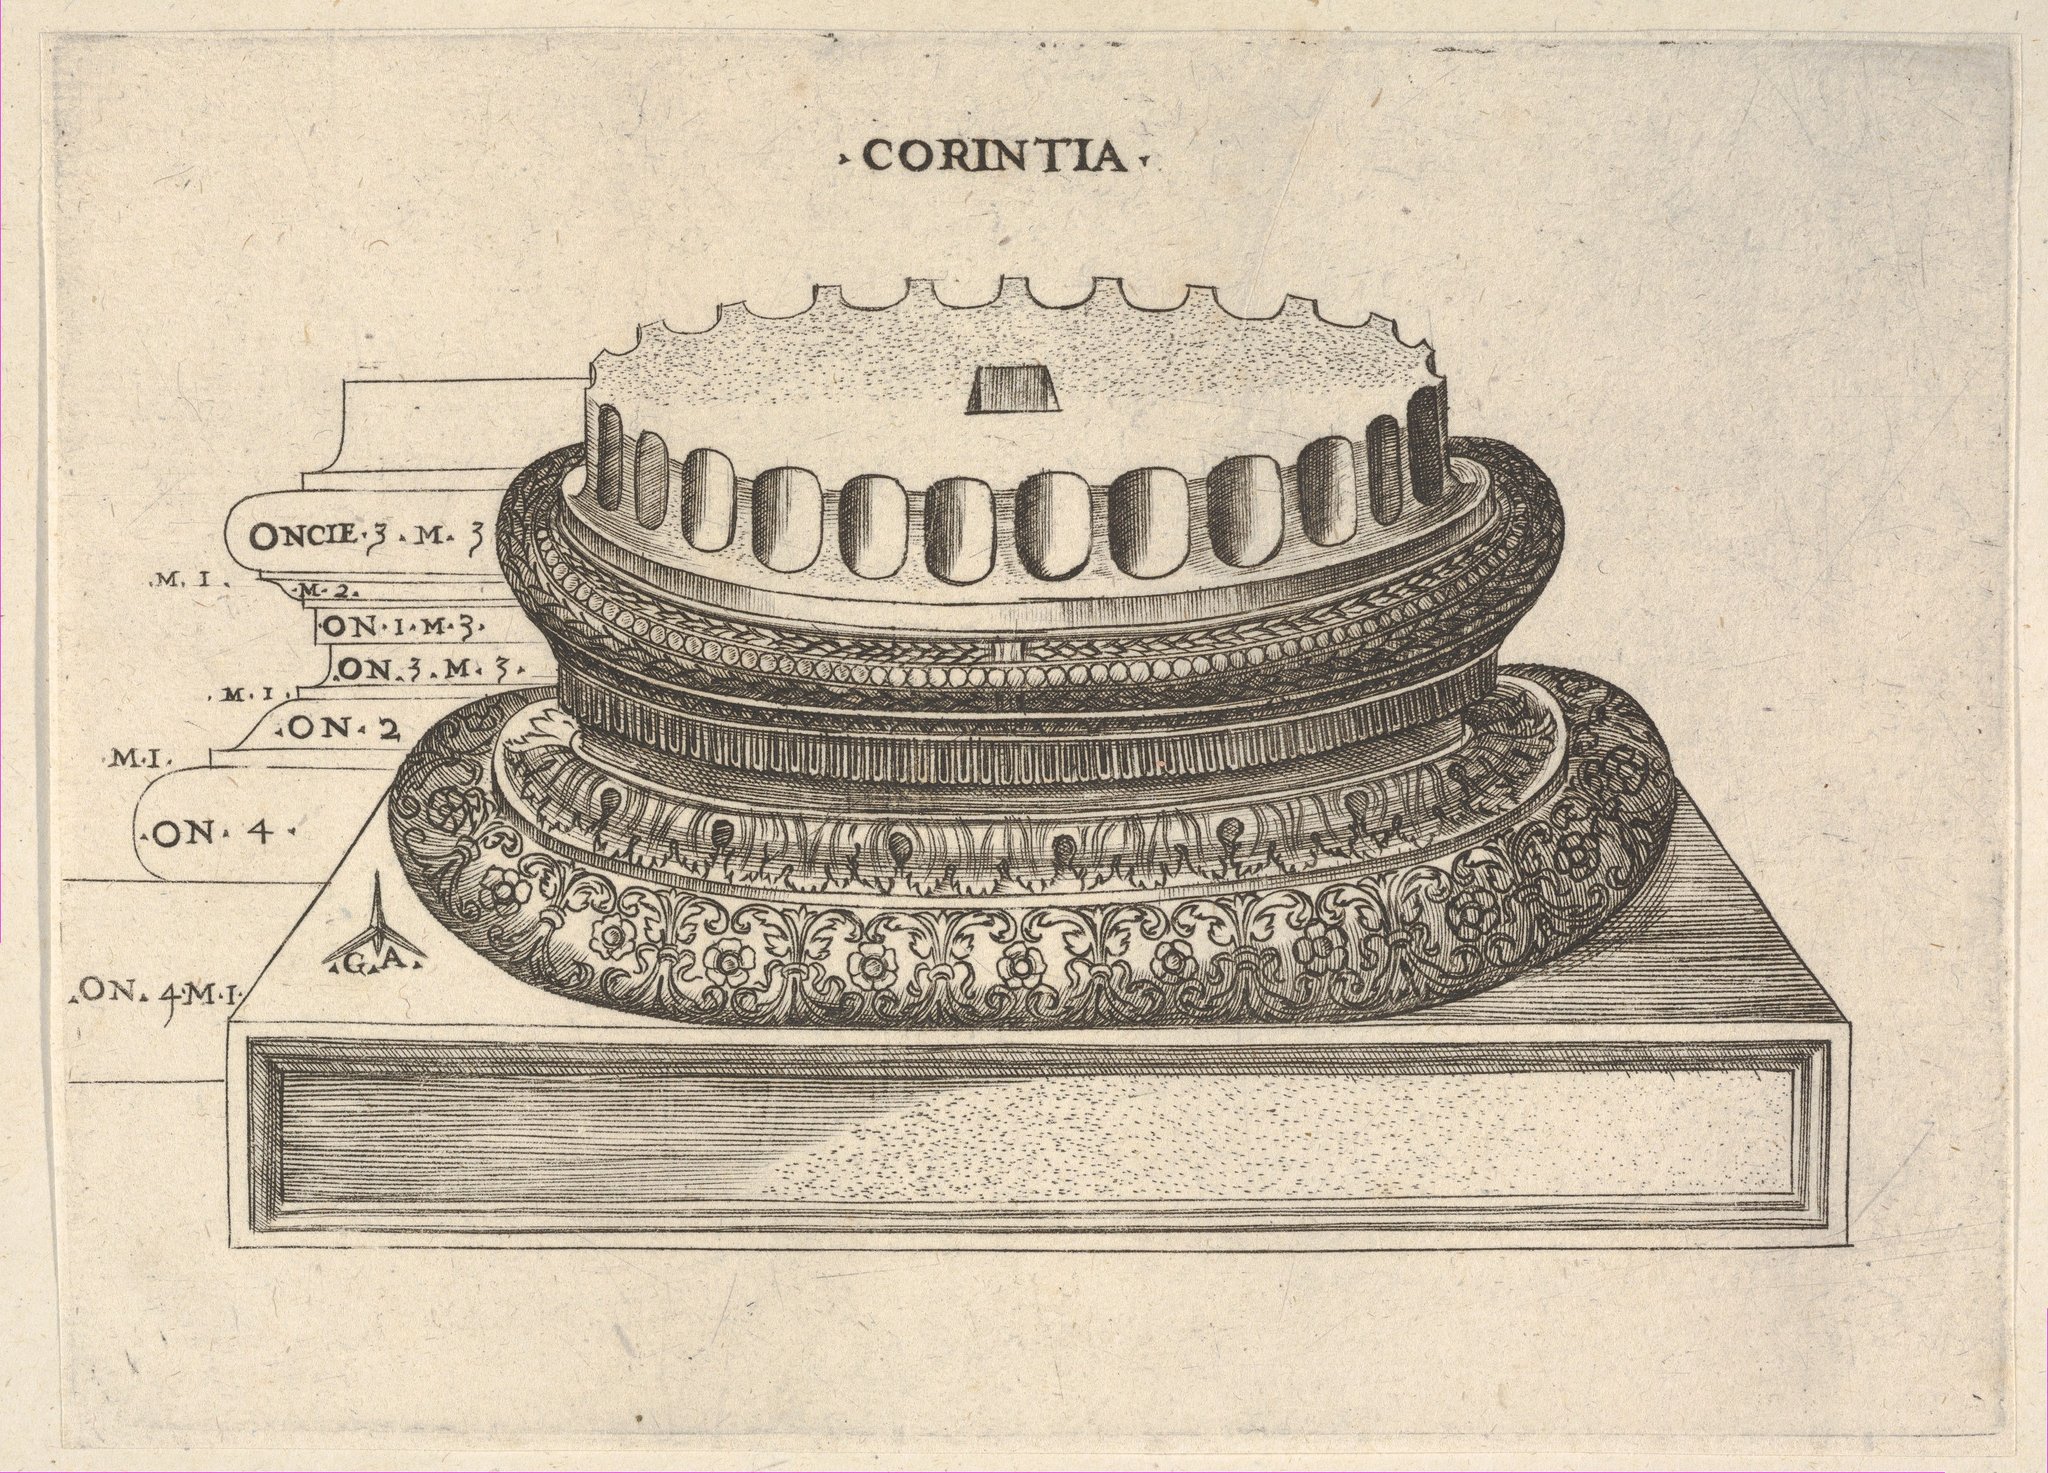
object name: print ornament architecture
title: Corinthian Base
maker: monogrammist g.a. with the caltrop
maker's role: artist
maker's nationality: italian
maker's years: 1535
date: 1530-1540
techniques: engraving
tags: architecture